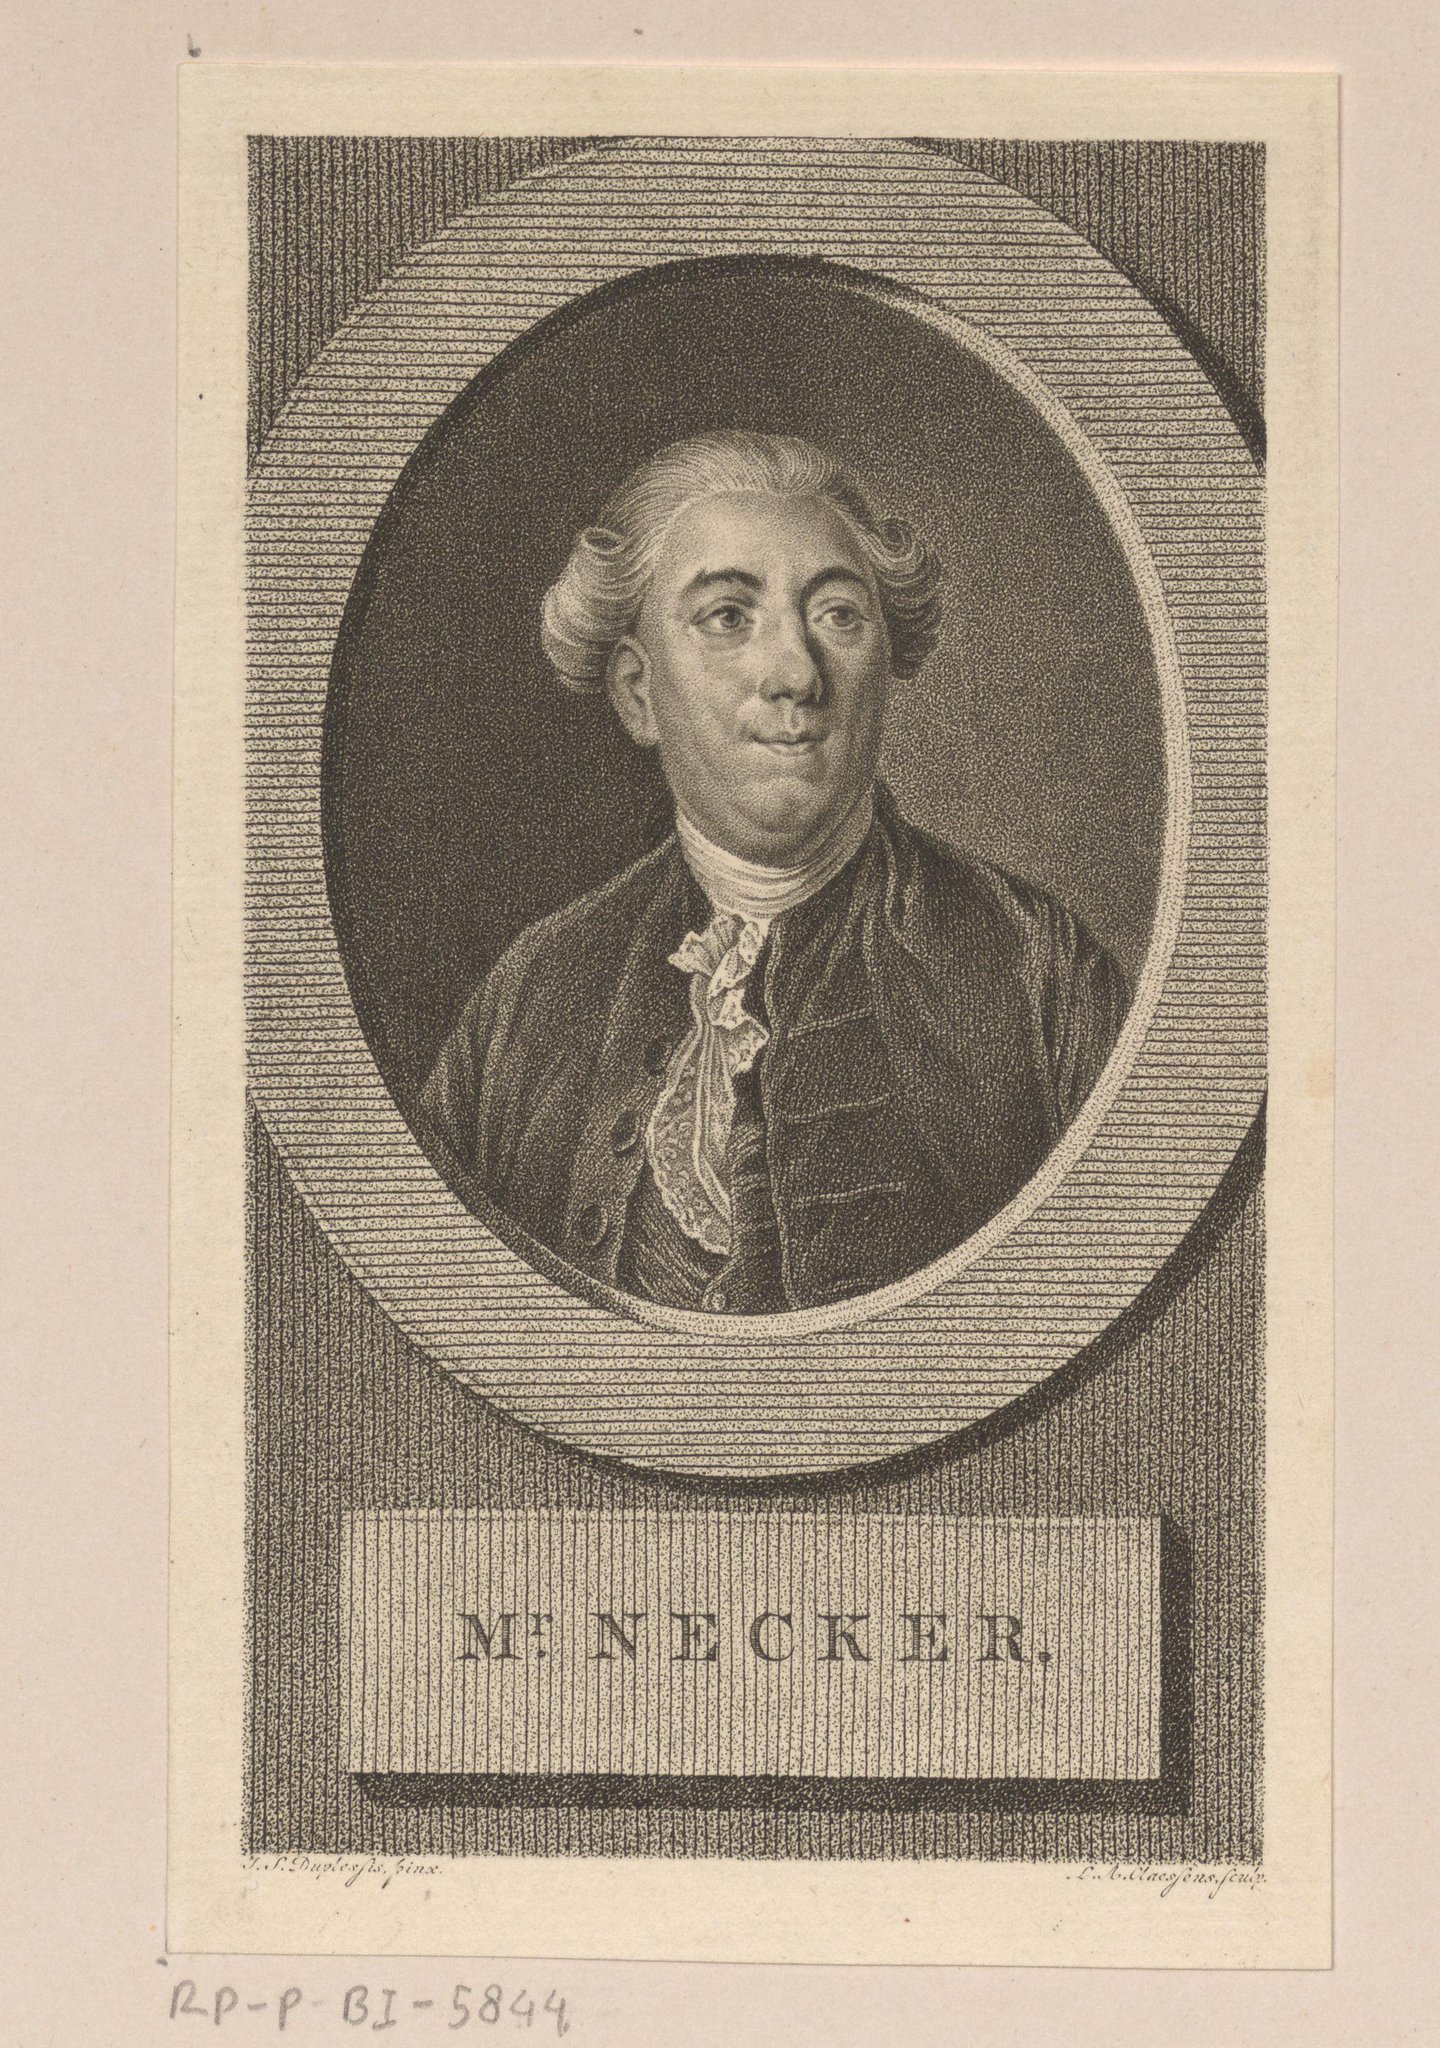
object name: print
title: Portret van Jacques Necker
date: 1774-1834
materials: paper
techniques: engraving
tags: minister ~ government, historical persons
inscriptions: collector's mark: Lugt 2228